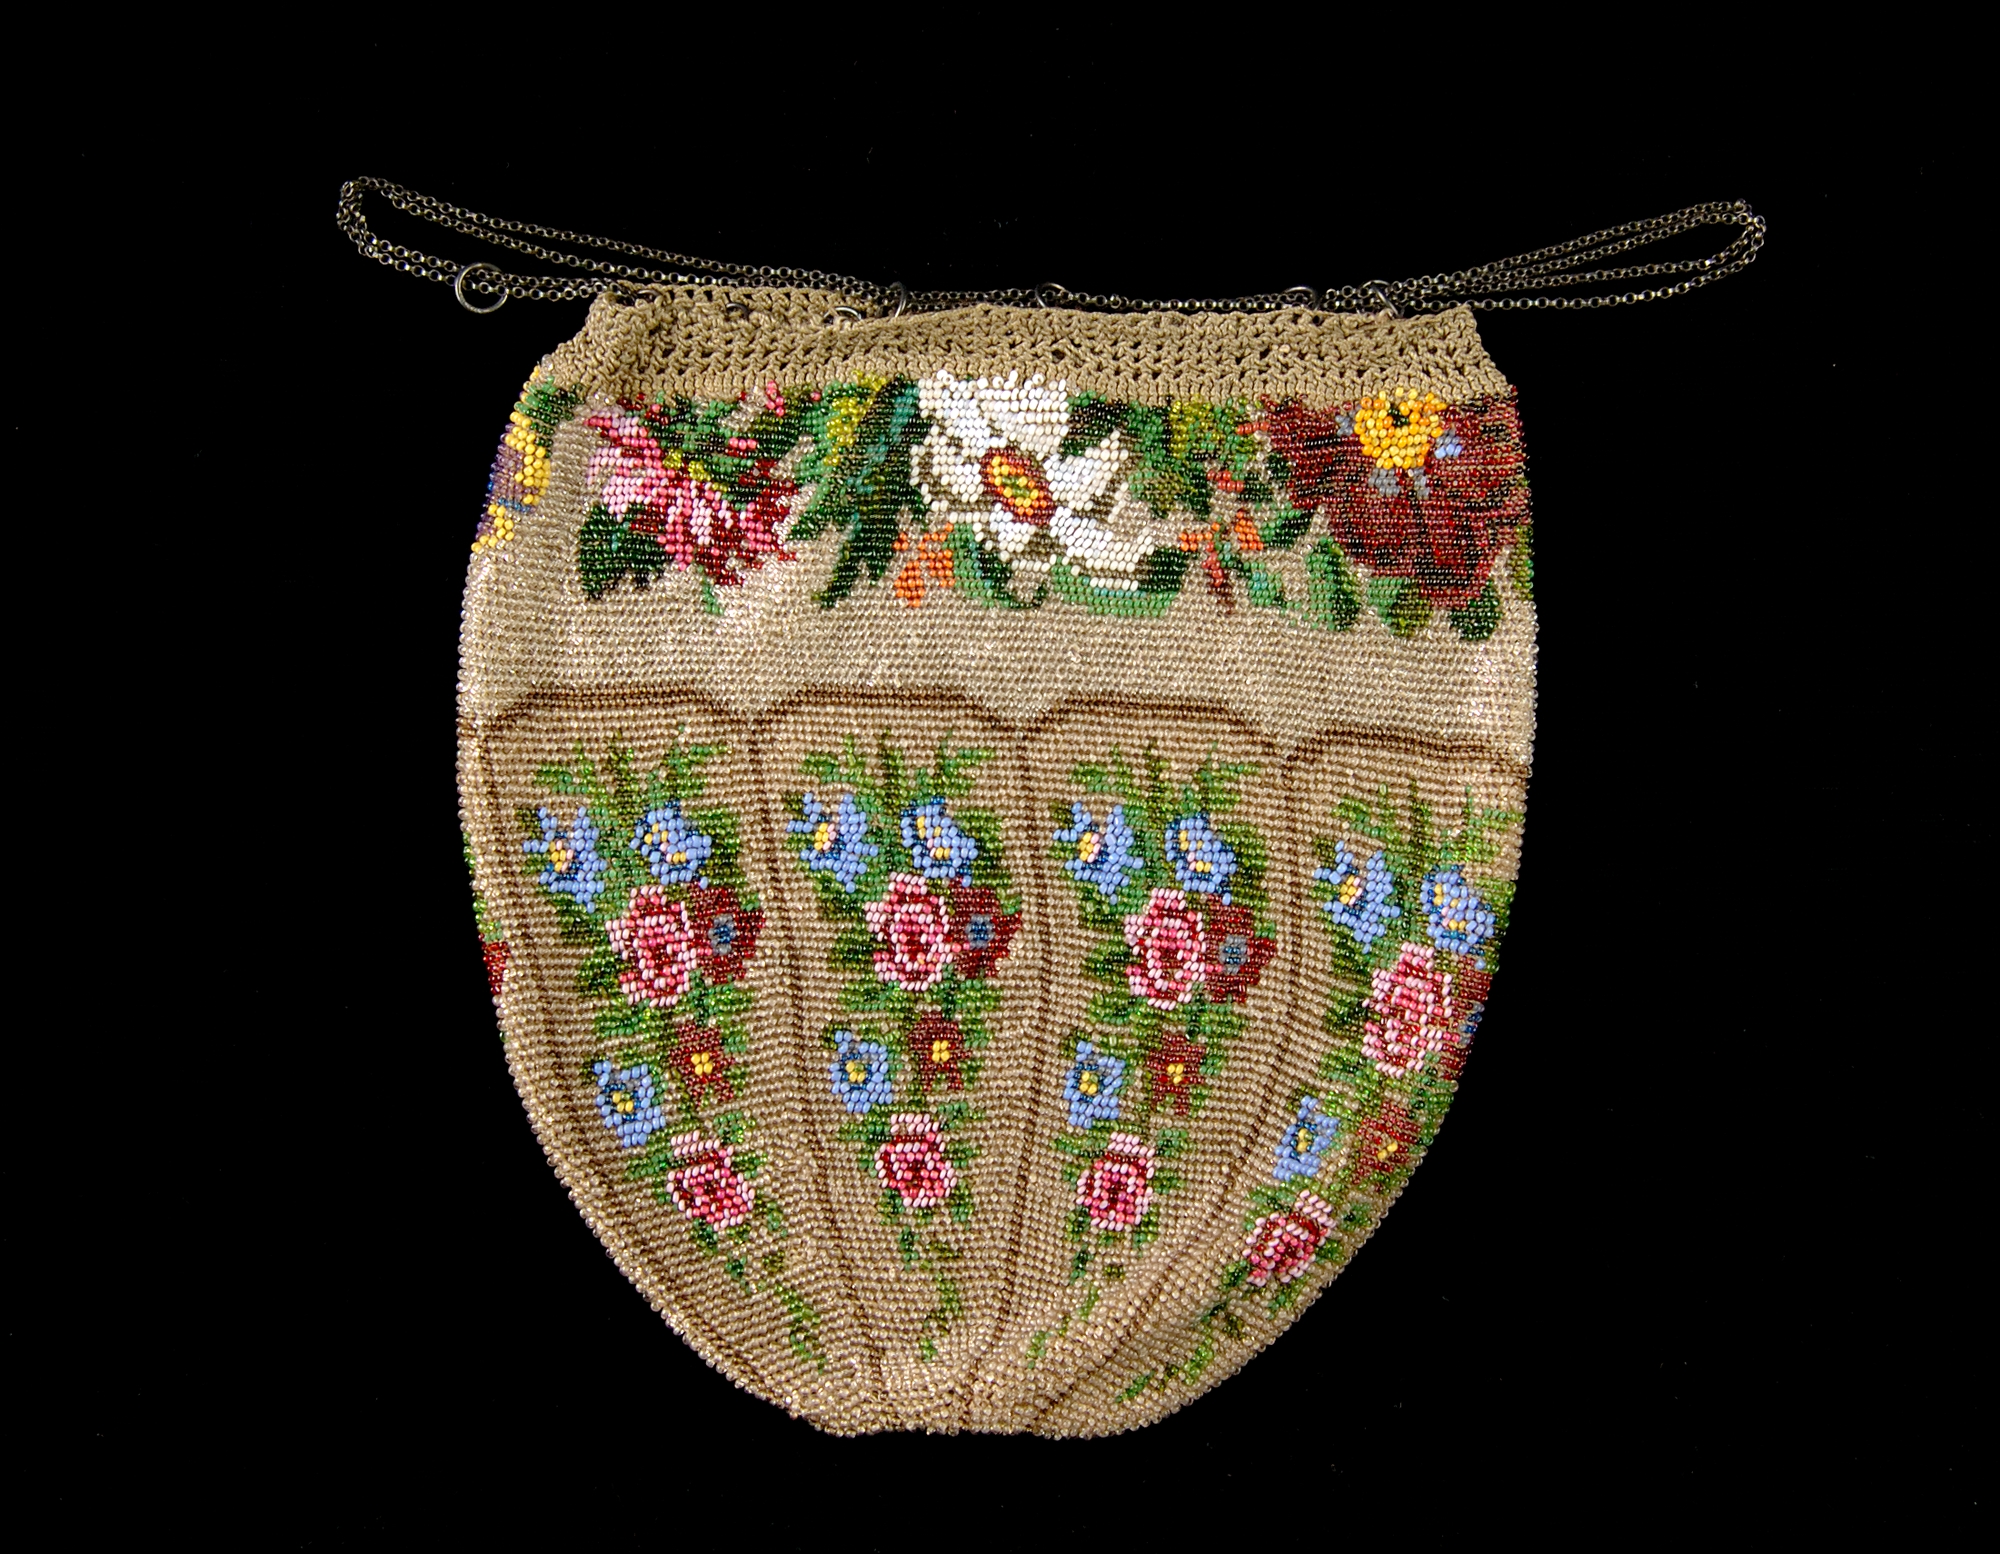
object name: pouch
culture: american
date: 1860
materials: glass, linen